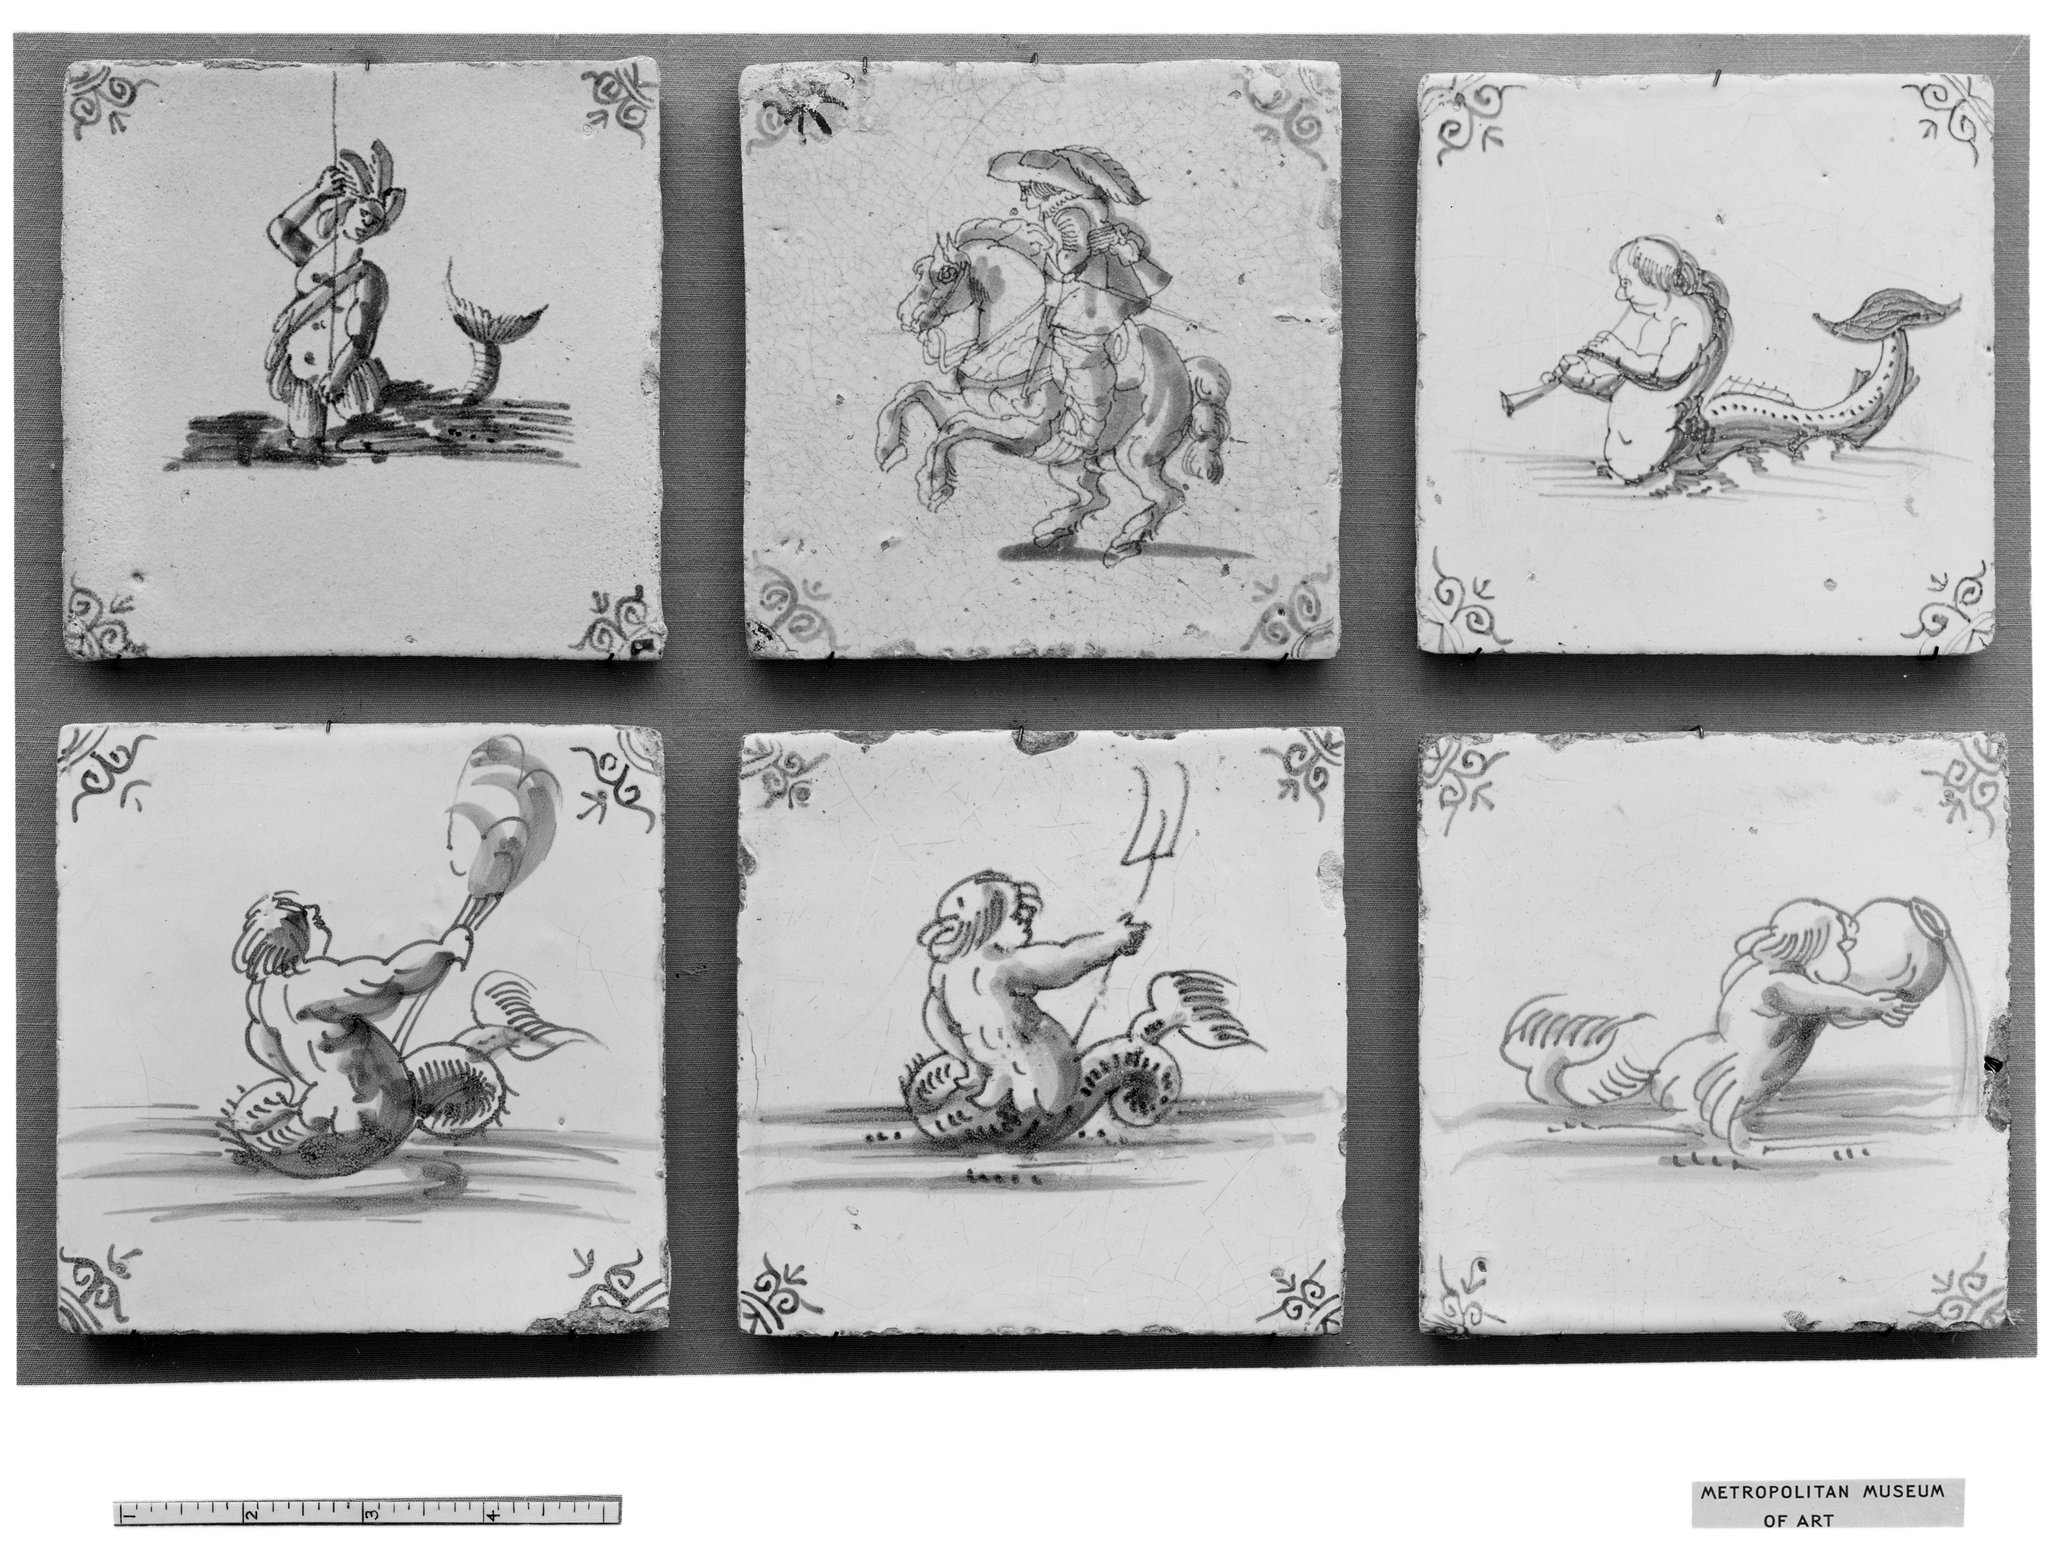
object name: tile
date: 1640-1660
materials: earthenware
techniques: glazing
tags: mermaids,horses